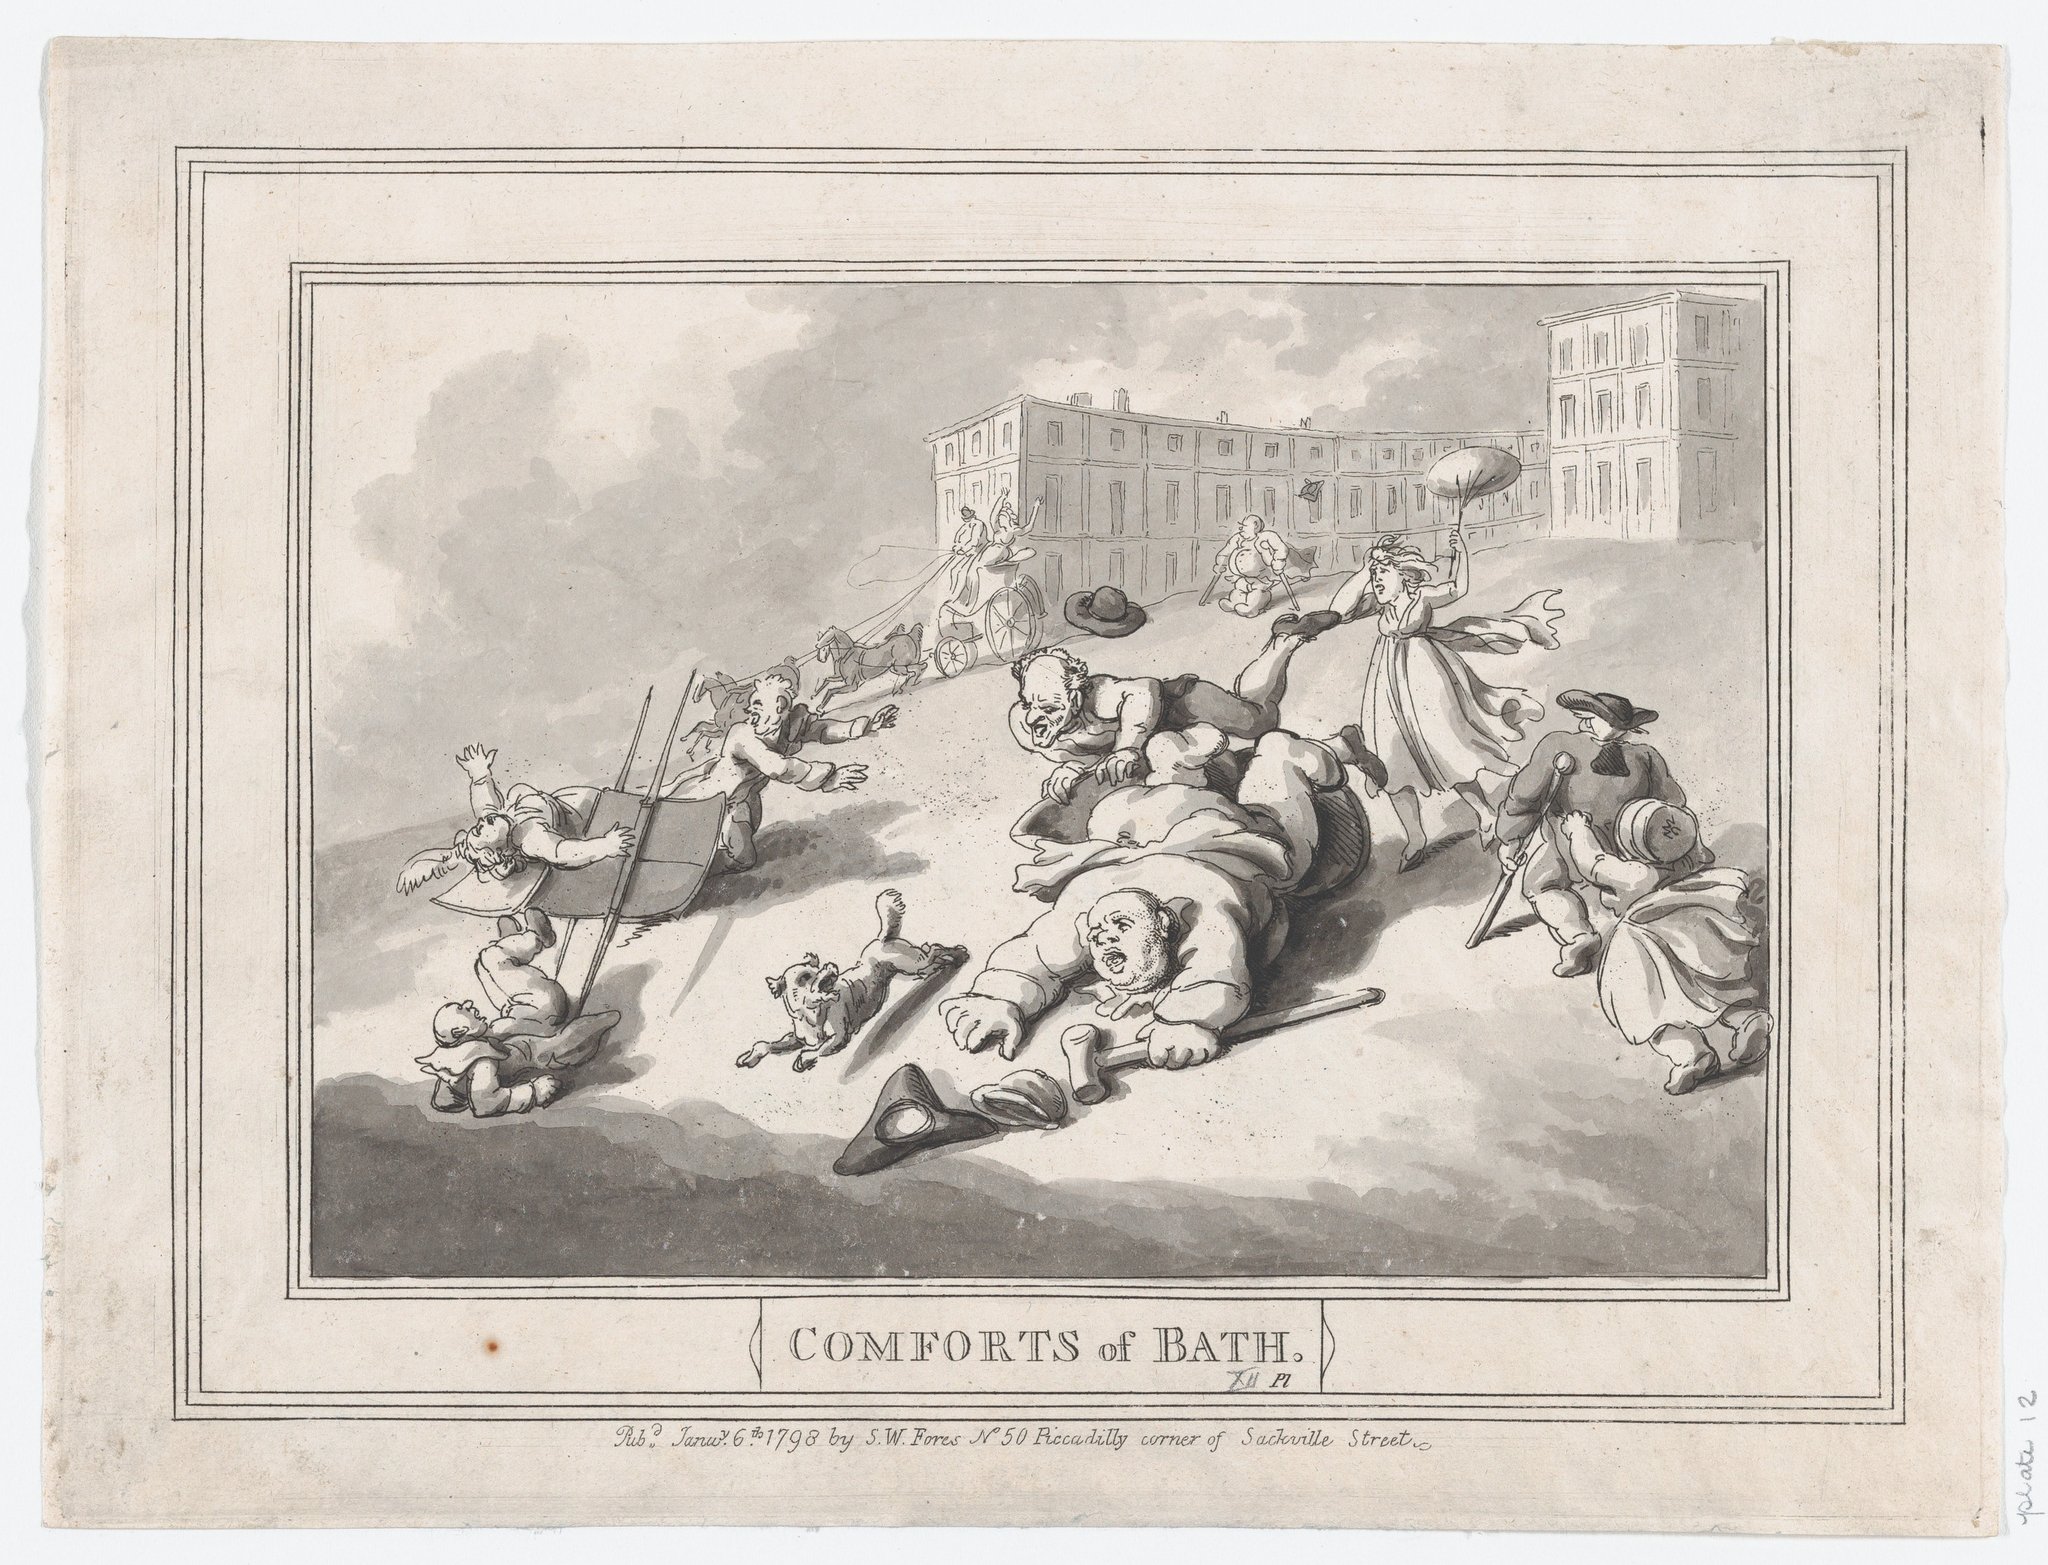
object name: print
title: Comforts of Bath, Plate 12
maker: thomas rowlandson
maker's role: artist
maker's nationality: british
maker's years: 1757-1827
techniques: aquatint, etching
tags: satire,men,women,dogs